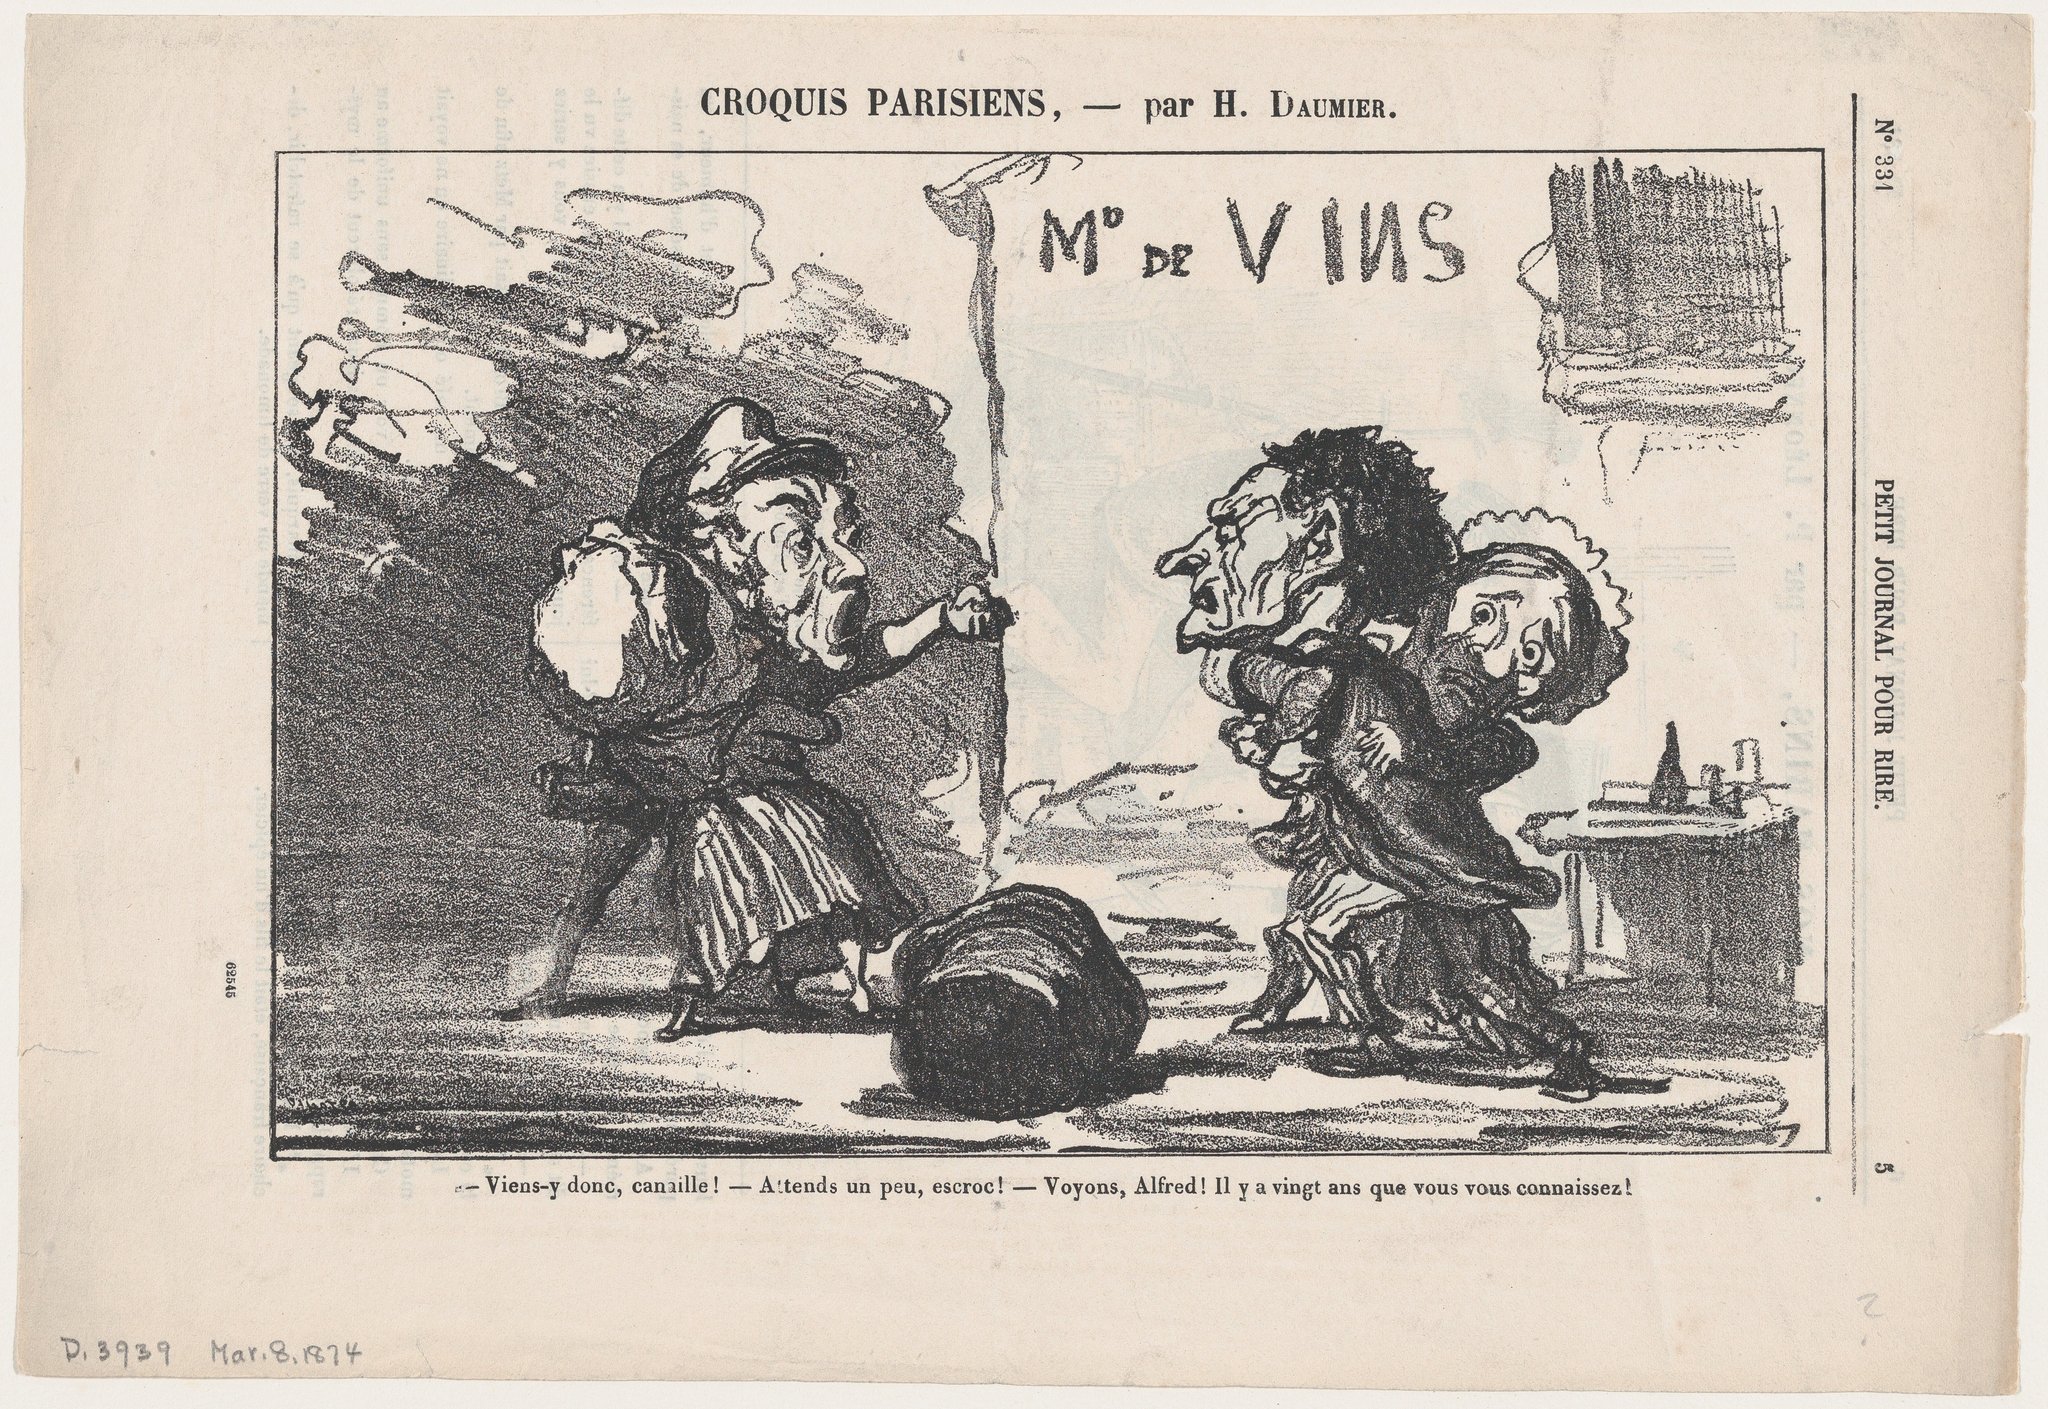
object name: print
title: –Come on, you scoundrel, come on! –Just you wait, you crook! –Oh come on Alfred, after all you've known each other for some twenty years!, from 'Parisian sketches,' published in Le Petit Journal pour Rire, March 8, 1874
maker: honoré daumier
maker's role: artist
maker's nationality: french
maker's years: 1808-1879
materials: paper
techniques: lithograph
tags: satire,men